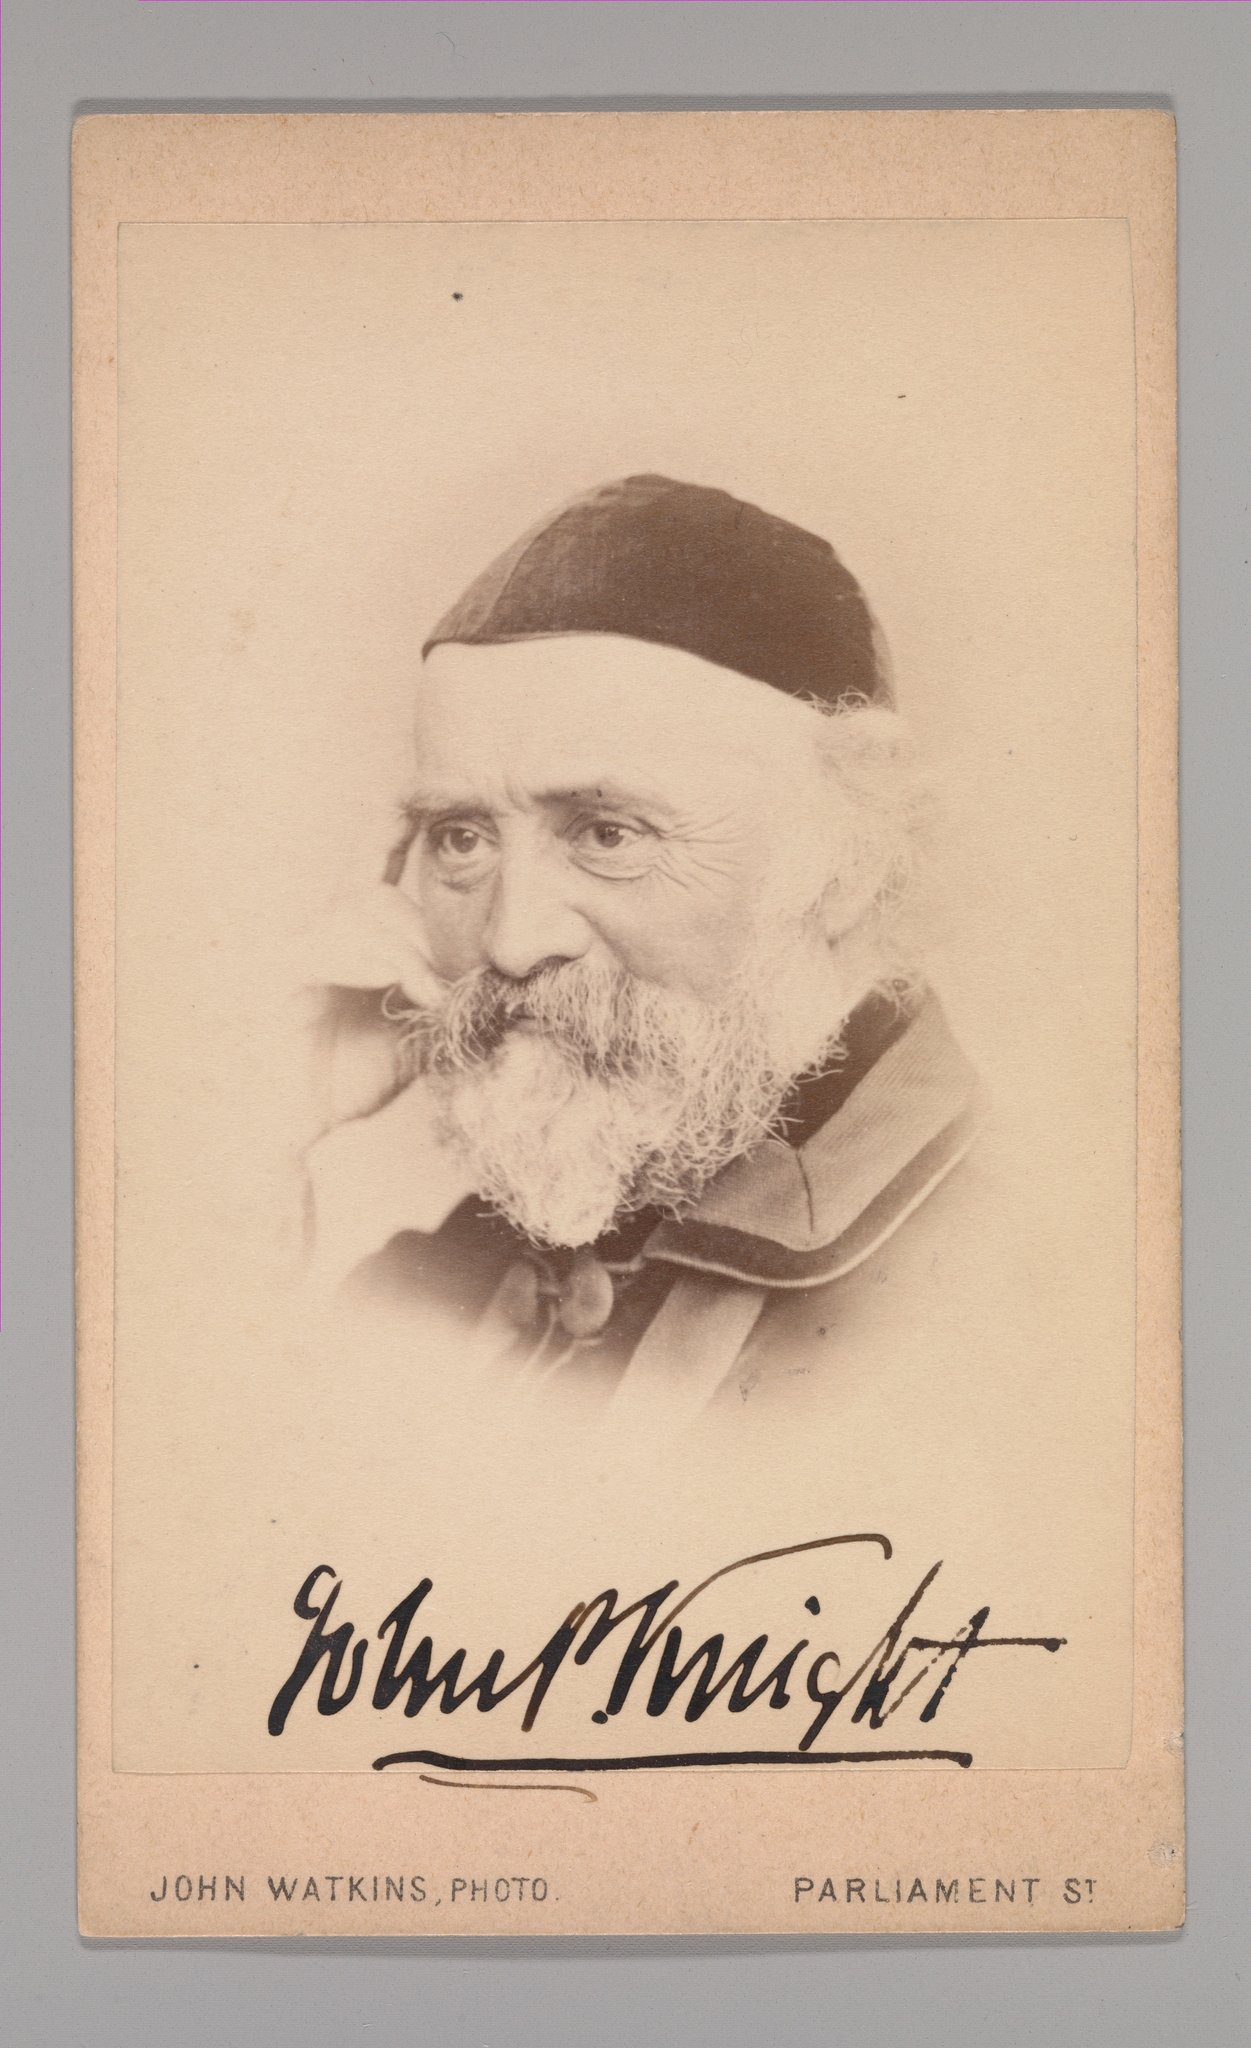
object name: carte de visite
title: [John Prescott Knight]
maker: john and charles watkins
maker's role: photography studio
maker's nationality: british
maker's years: 1840-1875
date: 1860-1869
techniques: albumen silver print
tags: men,portraits